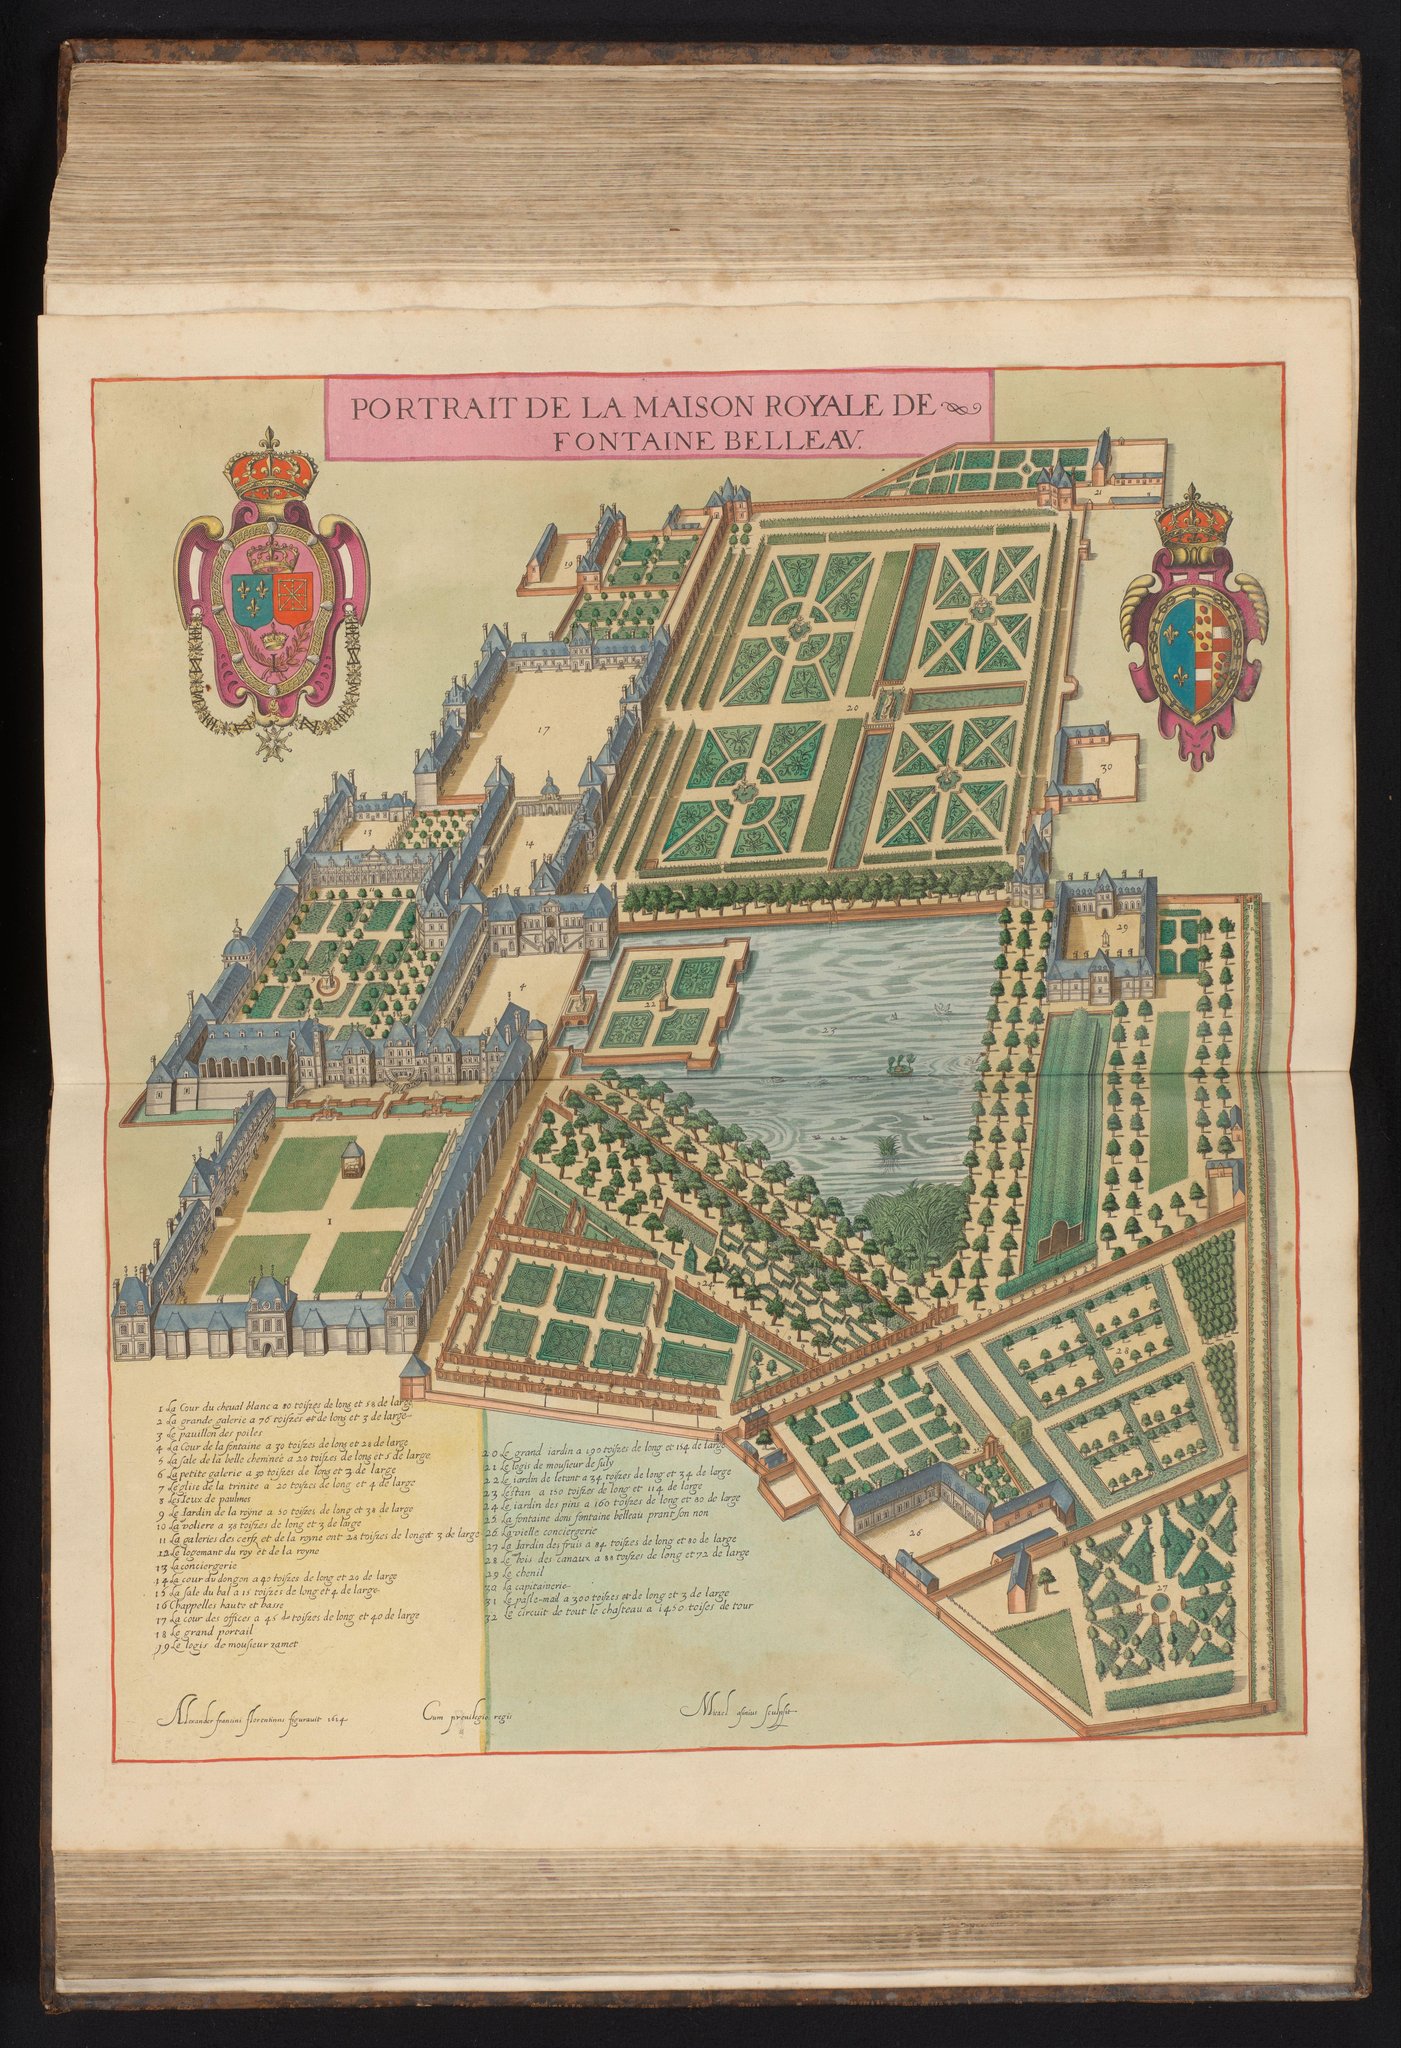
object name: album leaf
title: Portrait de la maison royale de Fontaine Belleau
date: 1614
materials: paper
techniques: engraving, hand coloring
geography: the hague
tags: cologne, print maker, maria de' medici, lodewijk xiii (koning van frankrijk), palace, french or architectonic garden; formal garden, bird's eye view ~ representation of building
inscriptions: date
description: Gezicht op het paleis en de tuinen van Fontainebleau. Linksboven het wapenschild van Lodewijk XIII, koning van Frankrijk. Rechtsboven het wapenschild van zijn moeder Maria de' Medici. Linksonder een index in het Frans. Prent maakt deel uit van een album.